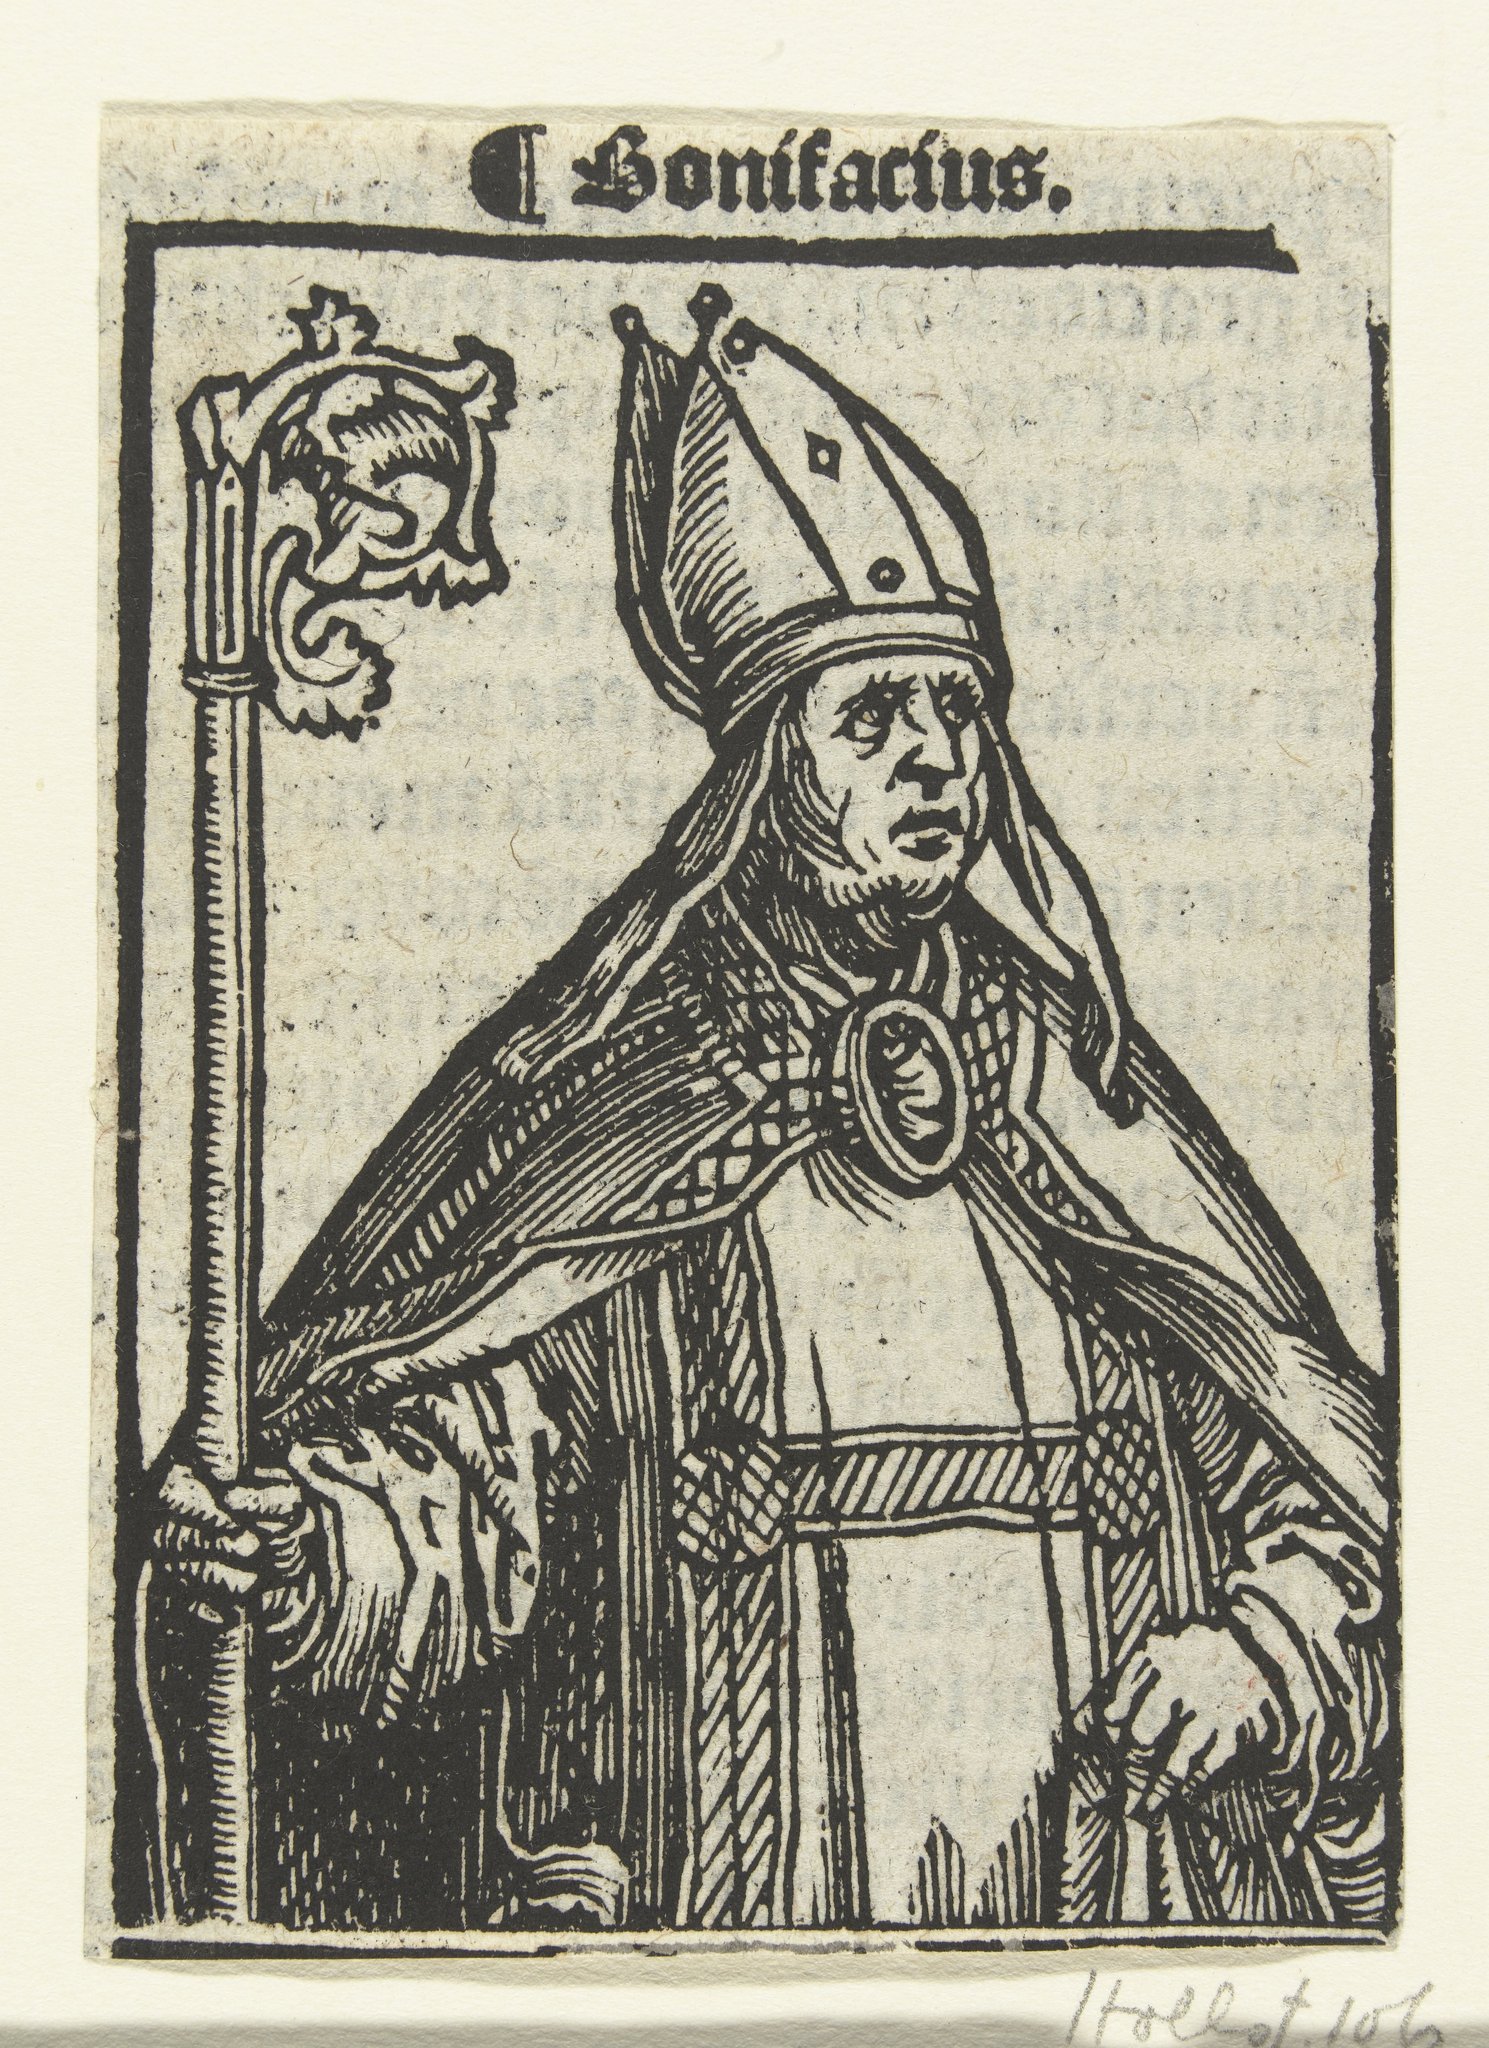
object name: book illustration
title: Bonifacius.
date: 1517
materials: paper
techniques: woodcut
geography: leiden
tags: the martyr boniface, 'apostle of germany', and archbishop of mainz; possible attributes: axe in root of tree, book pierced by a sword, fountain (springing up from under his staff), whip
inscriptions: collector's mark: Lugt 240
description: Uit "Cronycke van Hollandt, Zeelandt ende Vrieslant, uitgegeven door Jan Seversz. te Leiden. Houtsnede gebruikt in de editie van 1517 en van 1517-1530, folio 49v.